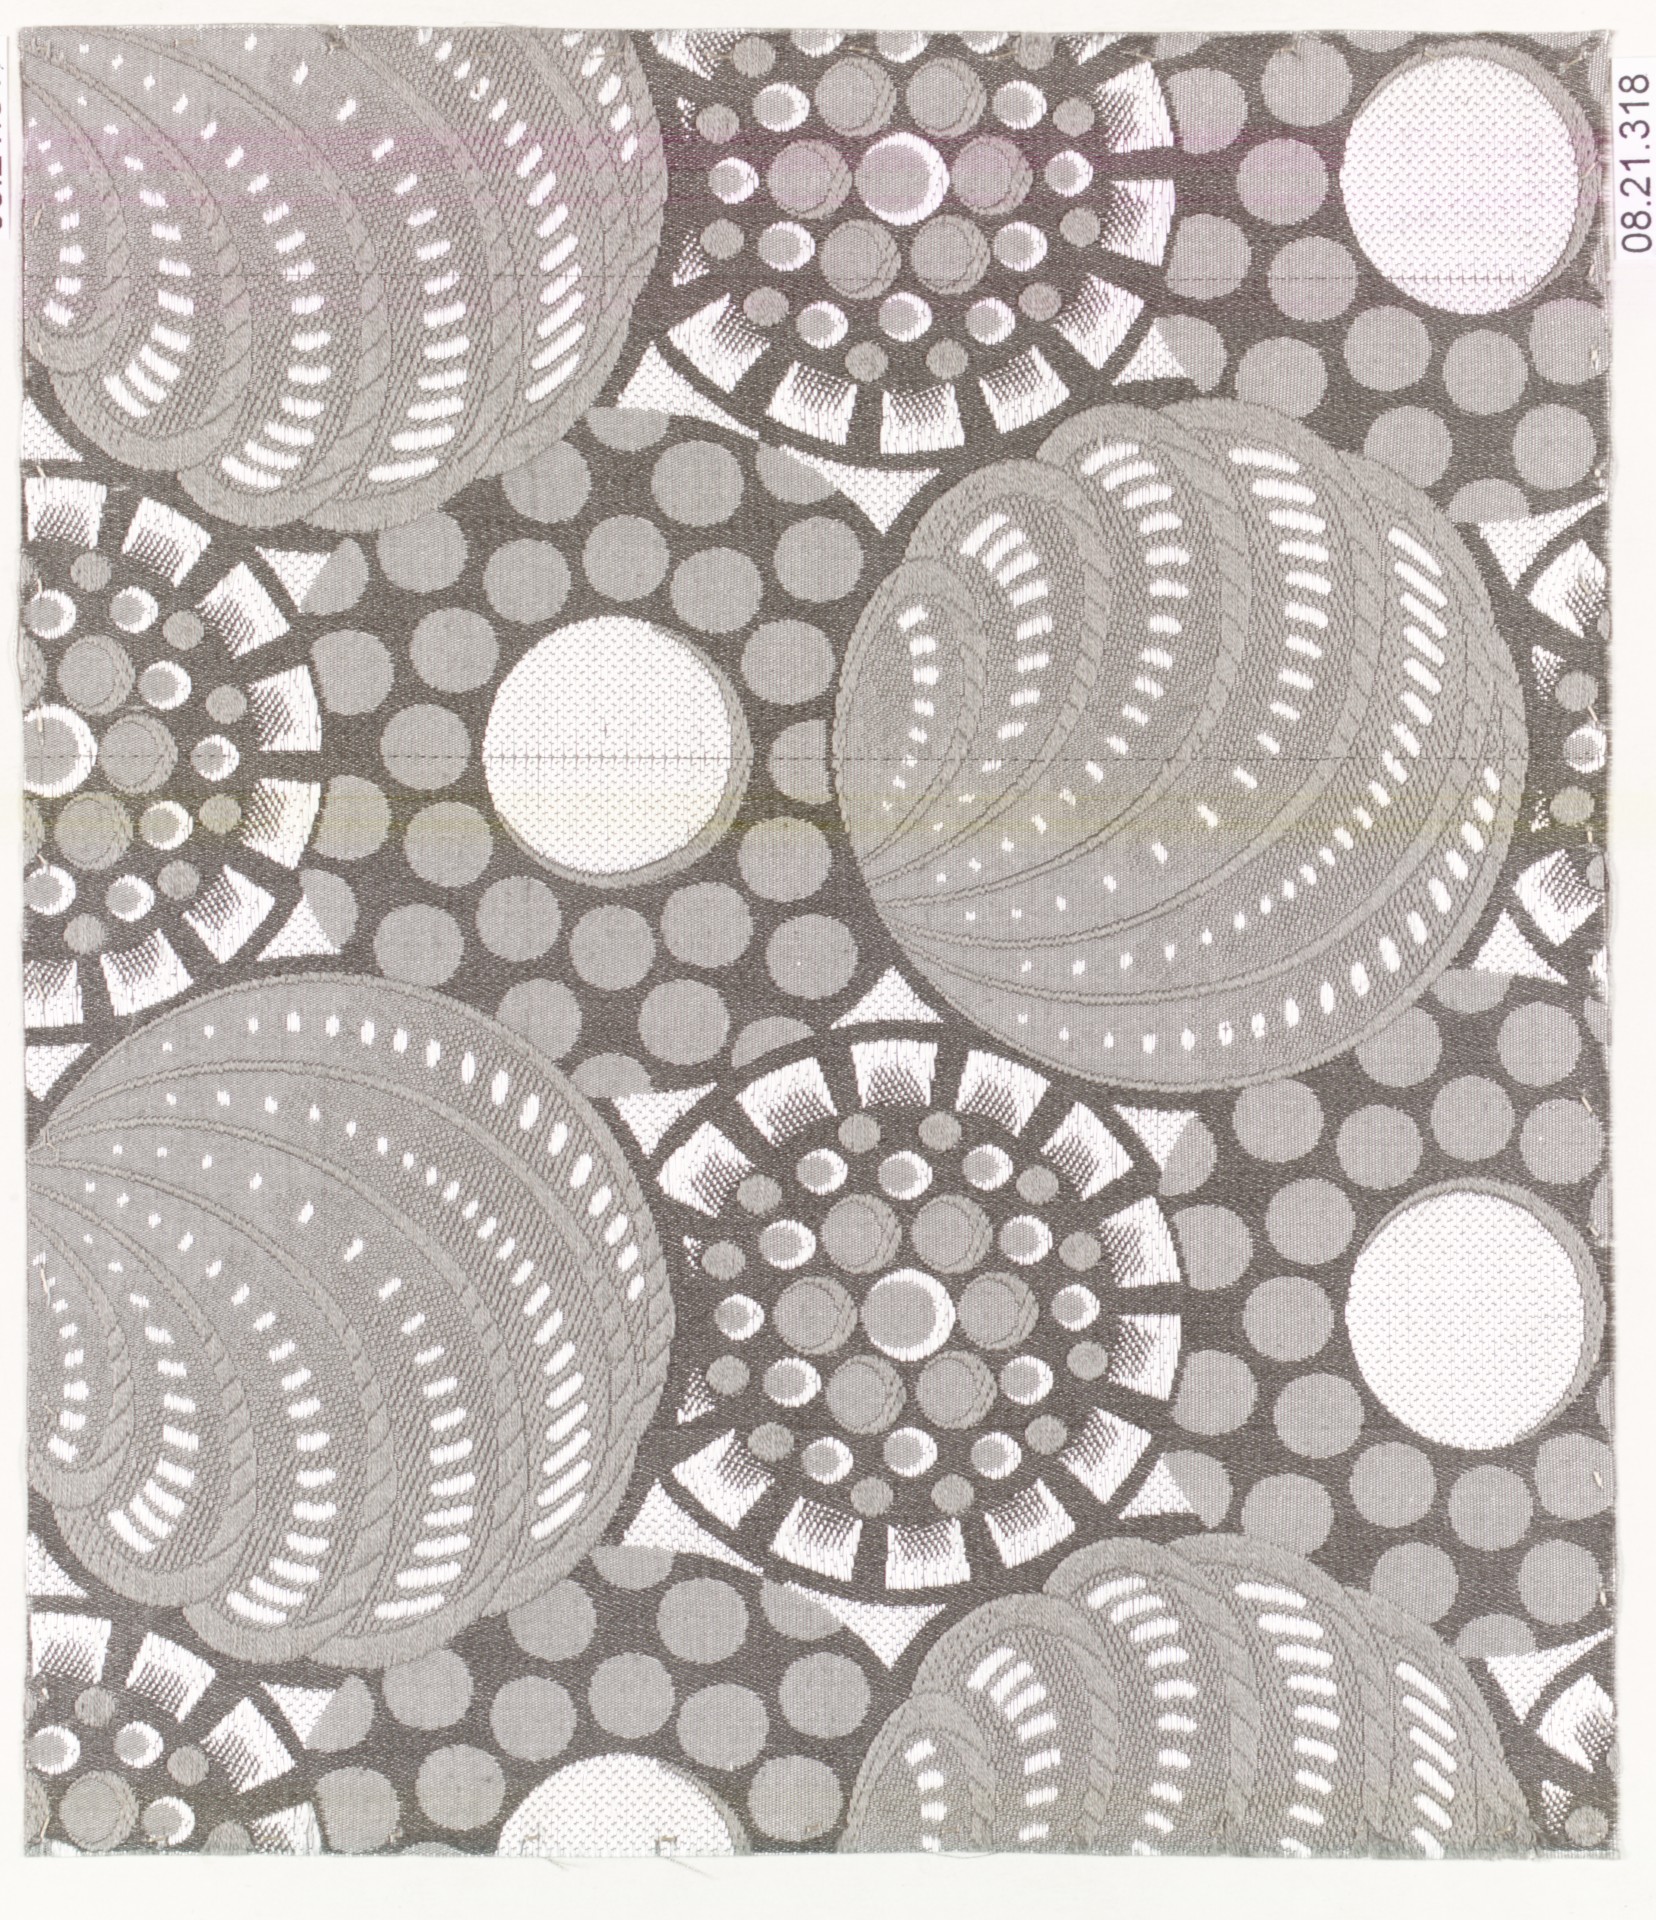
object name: textile sample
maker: Anonymous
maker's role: designer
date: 1900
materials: silk